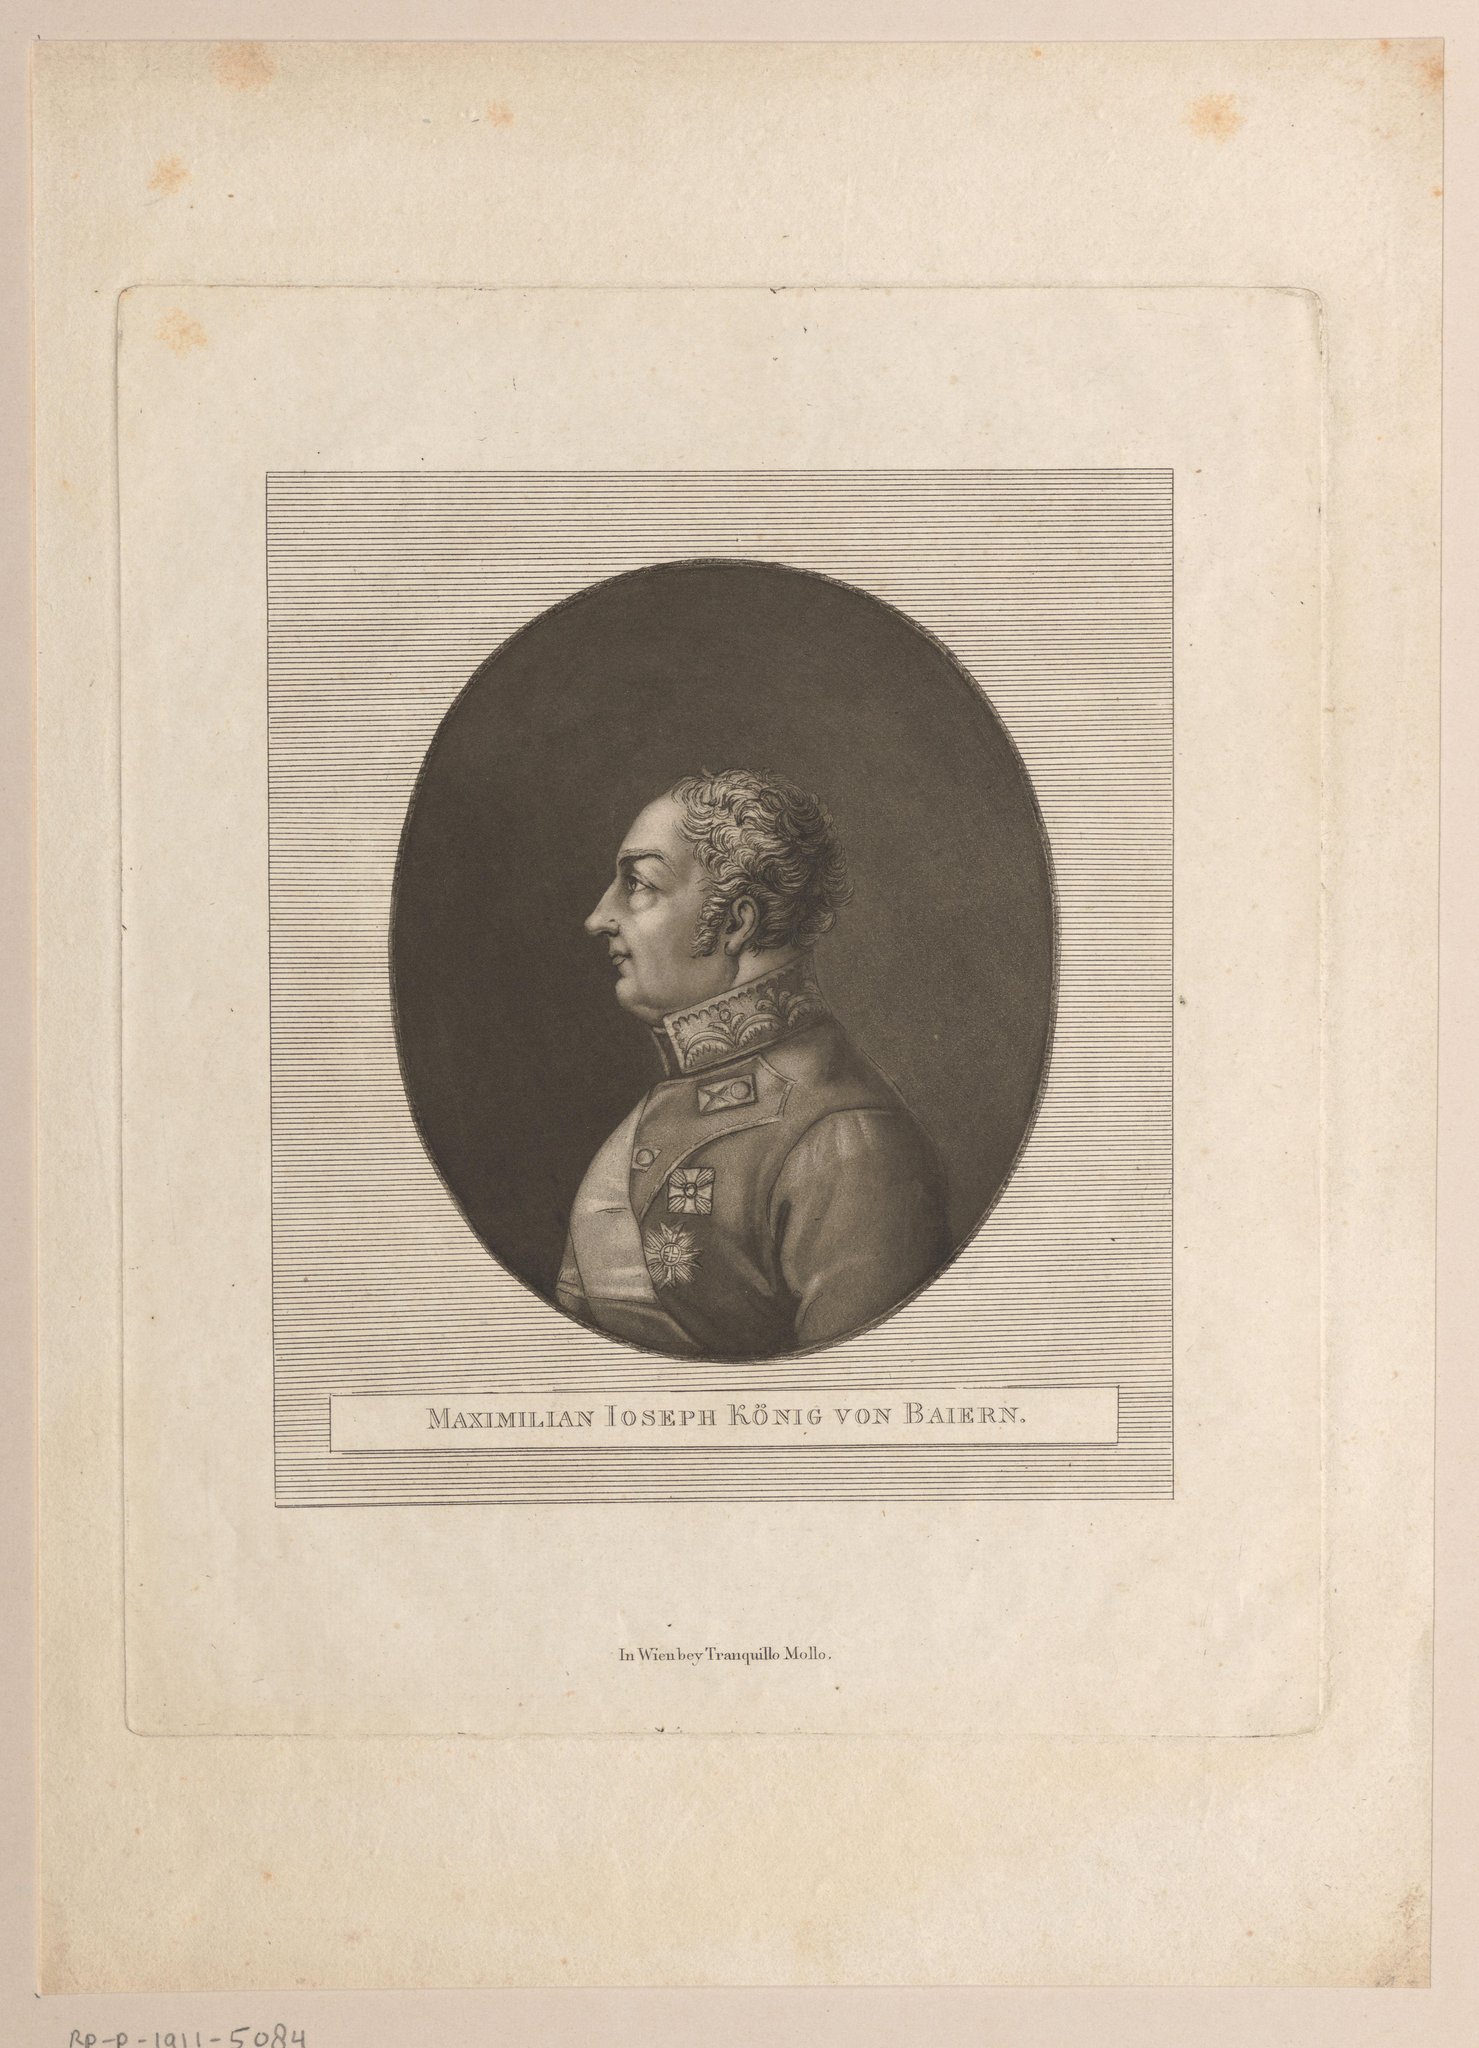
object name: print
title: Portret van Maximiliaan I Jozef van Beieren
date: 1806-1825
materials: paper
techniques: aquatint, etching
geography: vienna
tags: maximiliaan i jozef (koning van beieren), historical persons, (military) uniforms, king